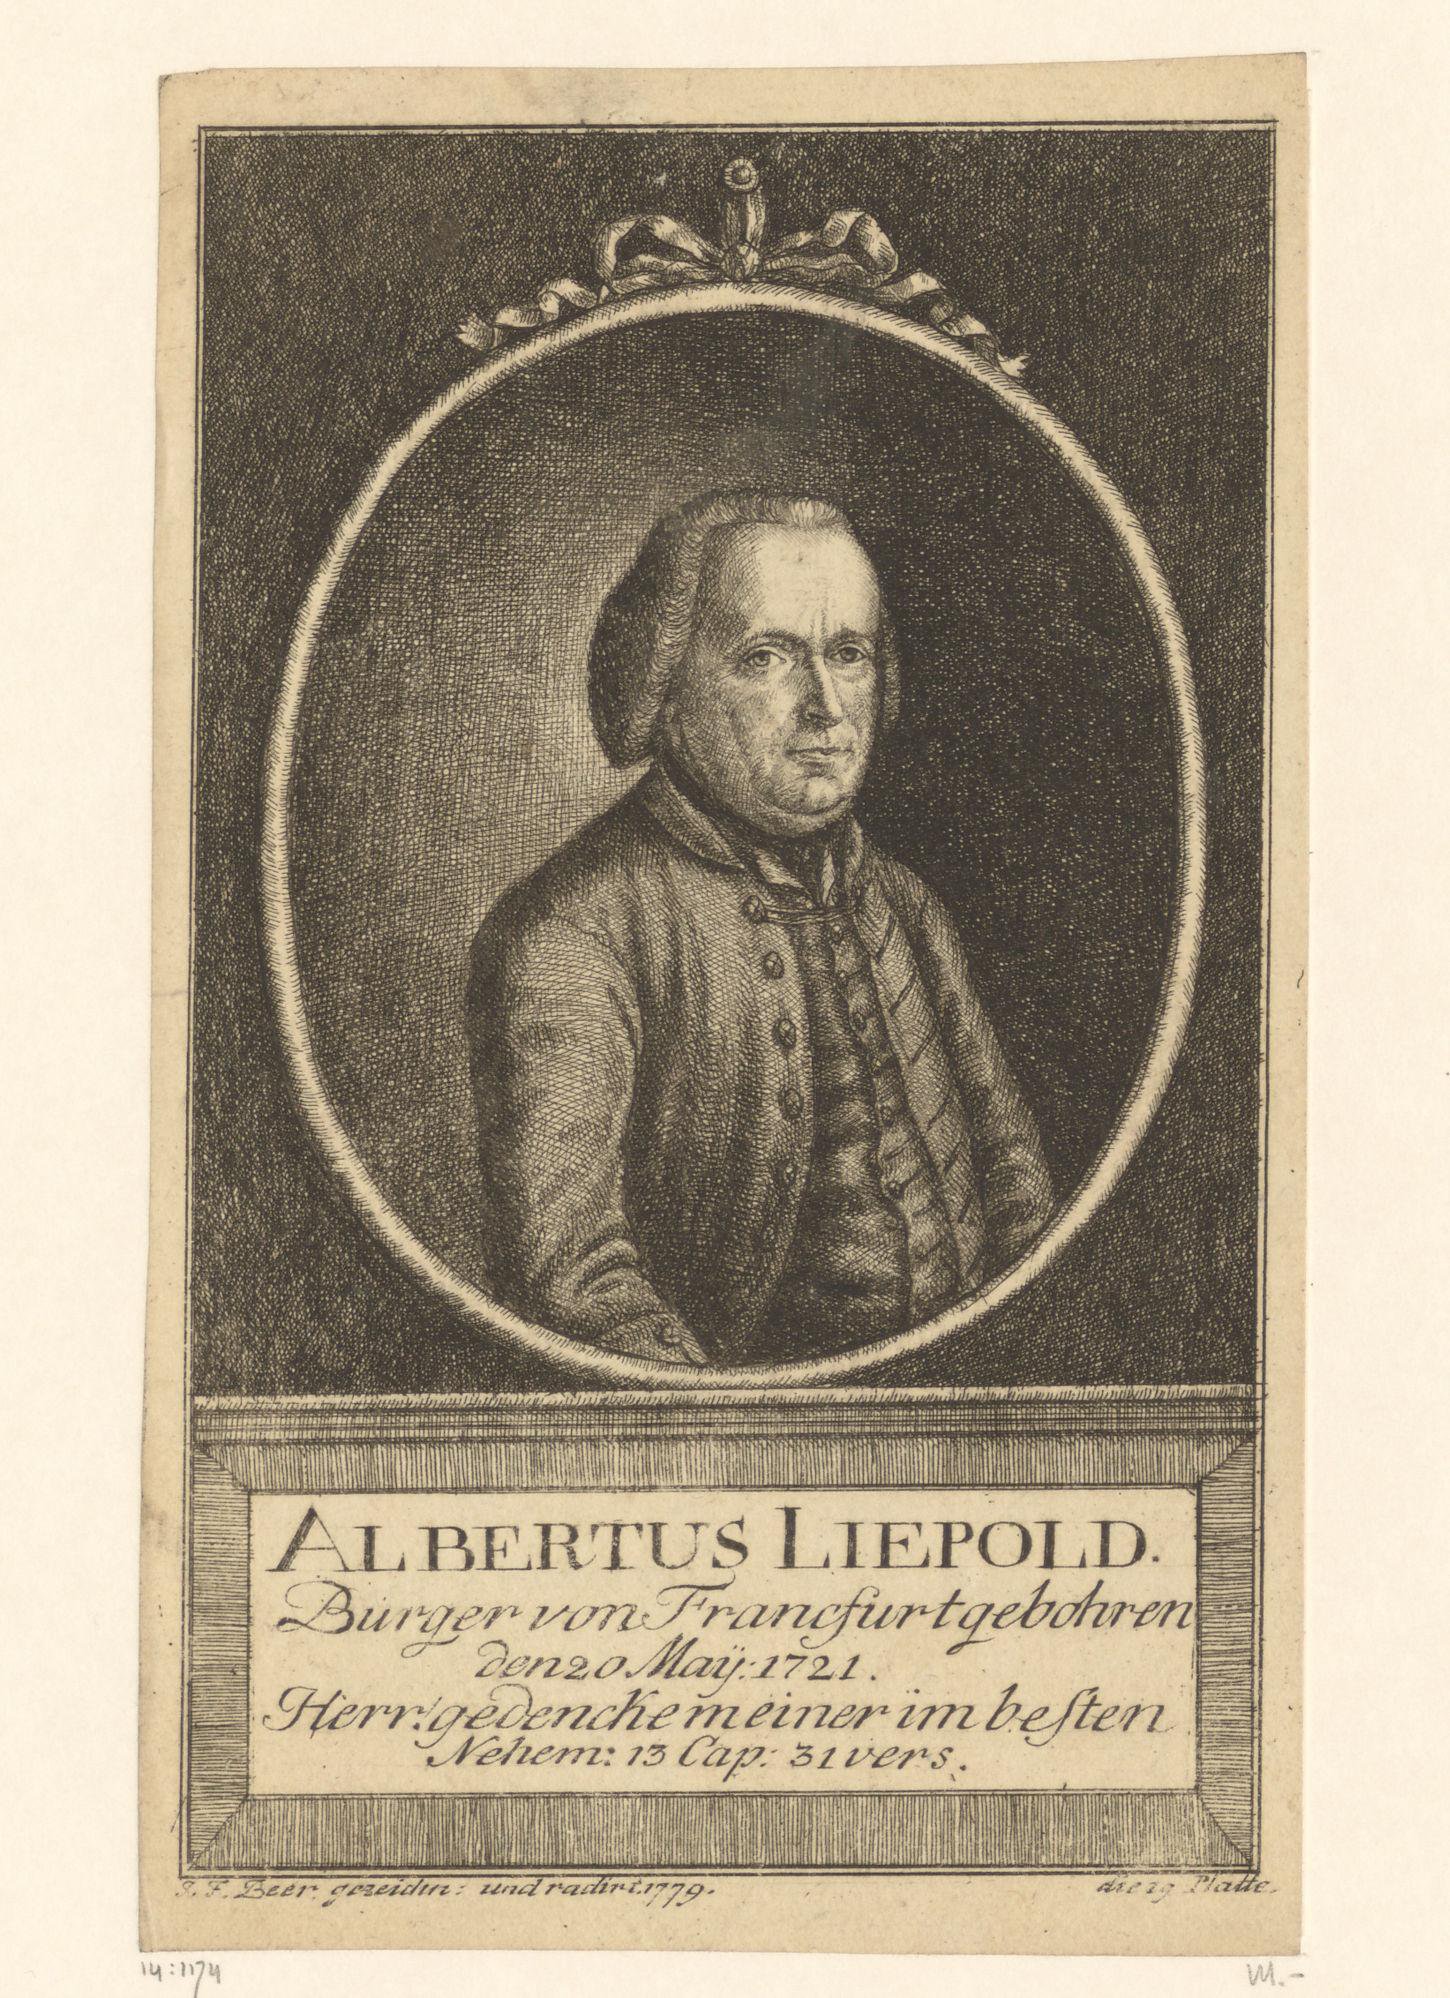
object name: print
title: Portret van Albertus Liepold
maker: johann friedrich beer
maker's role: print maker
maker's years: 1741-1804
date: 1751-1804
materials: paper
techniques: etching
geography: frankfurt am main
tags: historical persons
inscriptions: collector's mark: Lugt 2228